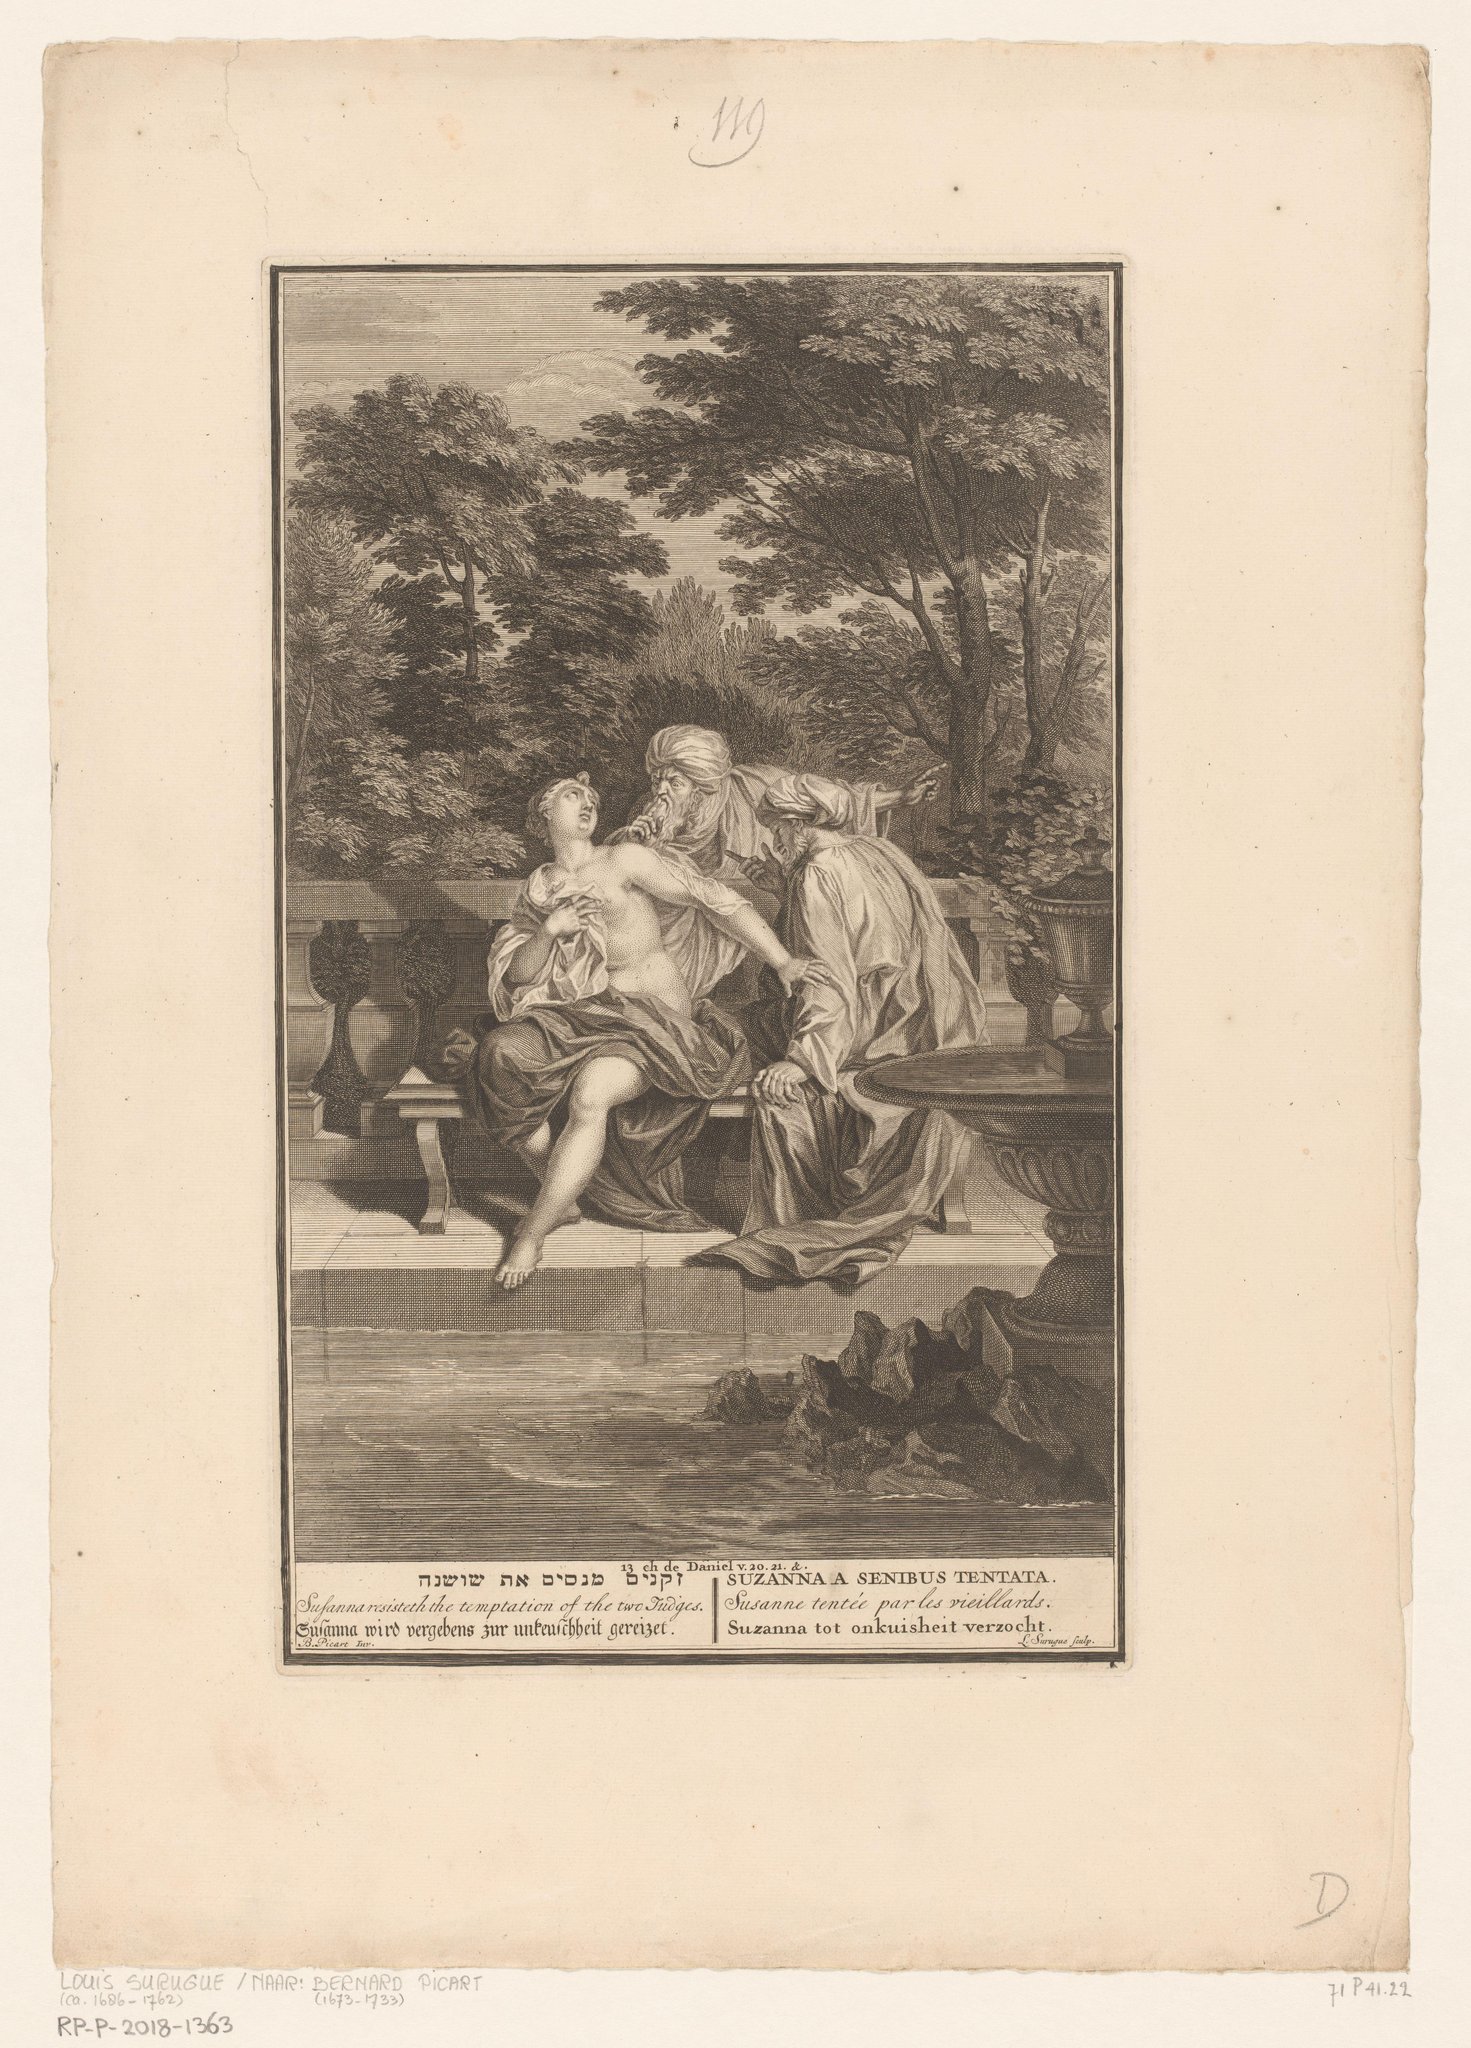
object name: print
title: Susanna en de ouderlingen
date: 1691-1733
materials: paper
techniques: engraving, etching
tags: the elders making advances towards susanna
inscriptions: collector's mark: Lugt 2228